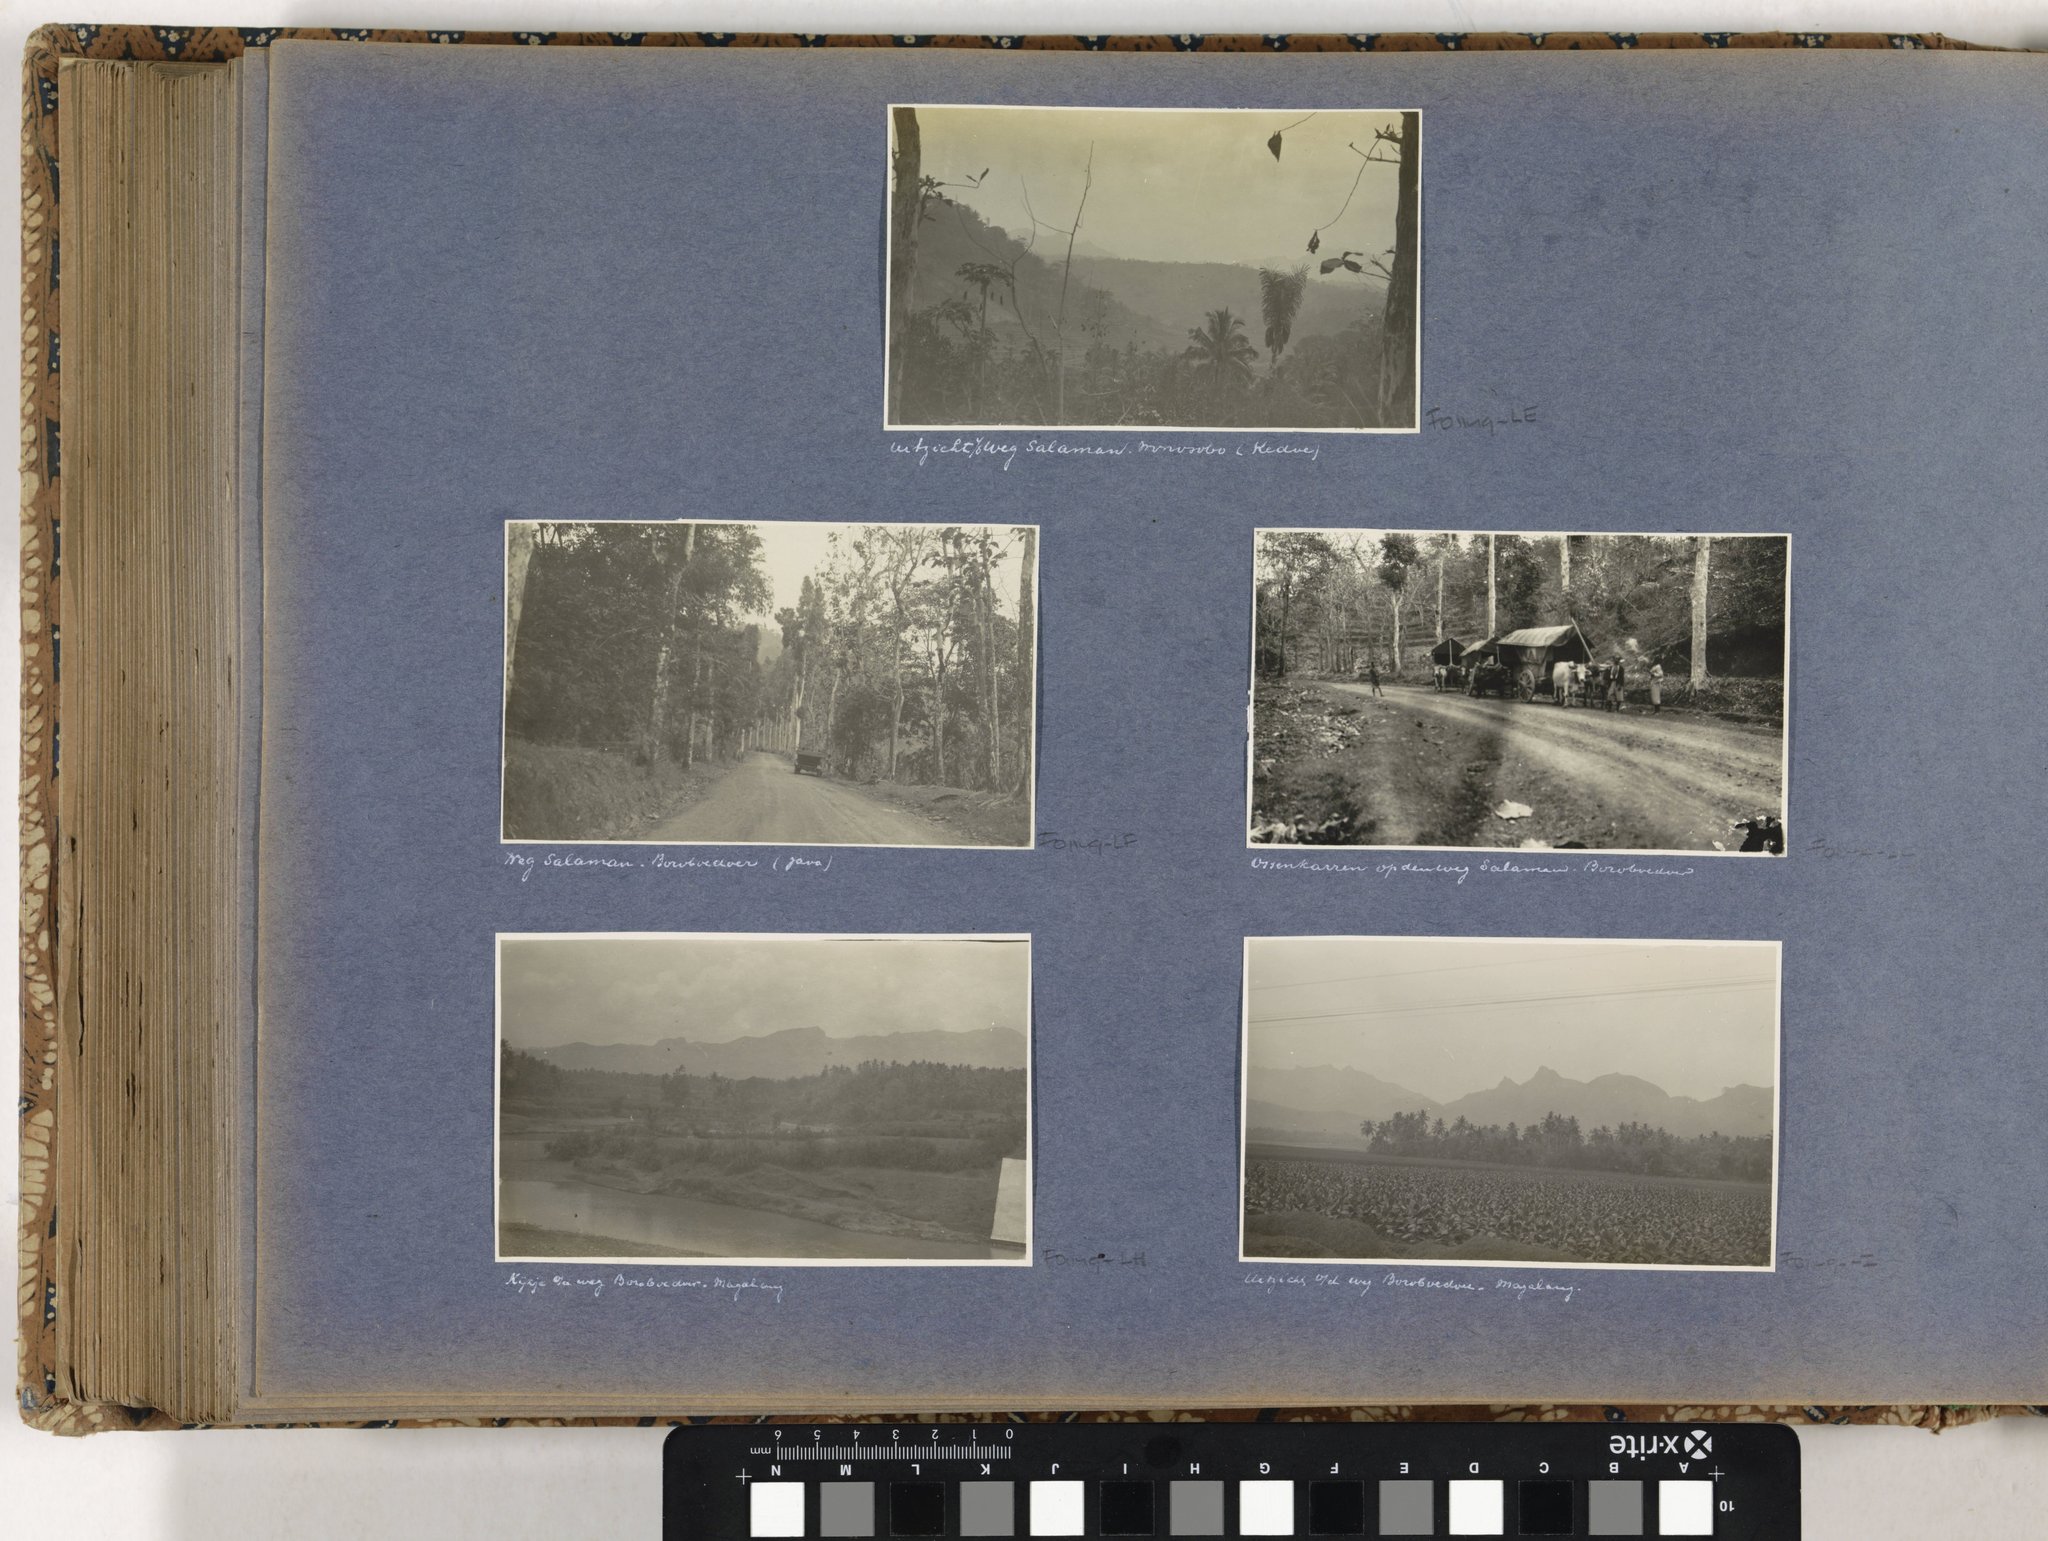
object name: photograph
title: Landschap langs de weg van Borobudur naar Magelang op Java, op de voorgrond gewassen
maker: Anonymous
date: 1900-1920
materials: paper, photographic support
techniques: gelatin silver print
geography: java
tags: field filled with a crop, mountains (in tropical and sub-tropical regions), java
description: Onderdeel van reisalbum met foto's van bedrijvigheid en bezienswaardigheden op Sumatra en Java en van de reis naar en van Nederlands-Indië.